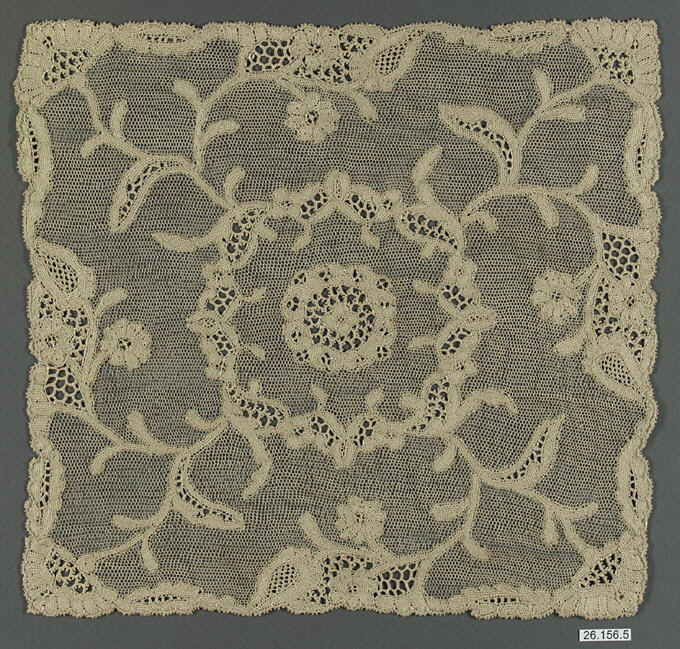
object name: square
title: Square (one of three)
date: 1701-1800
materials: silk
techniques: lace